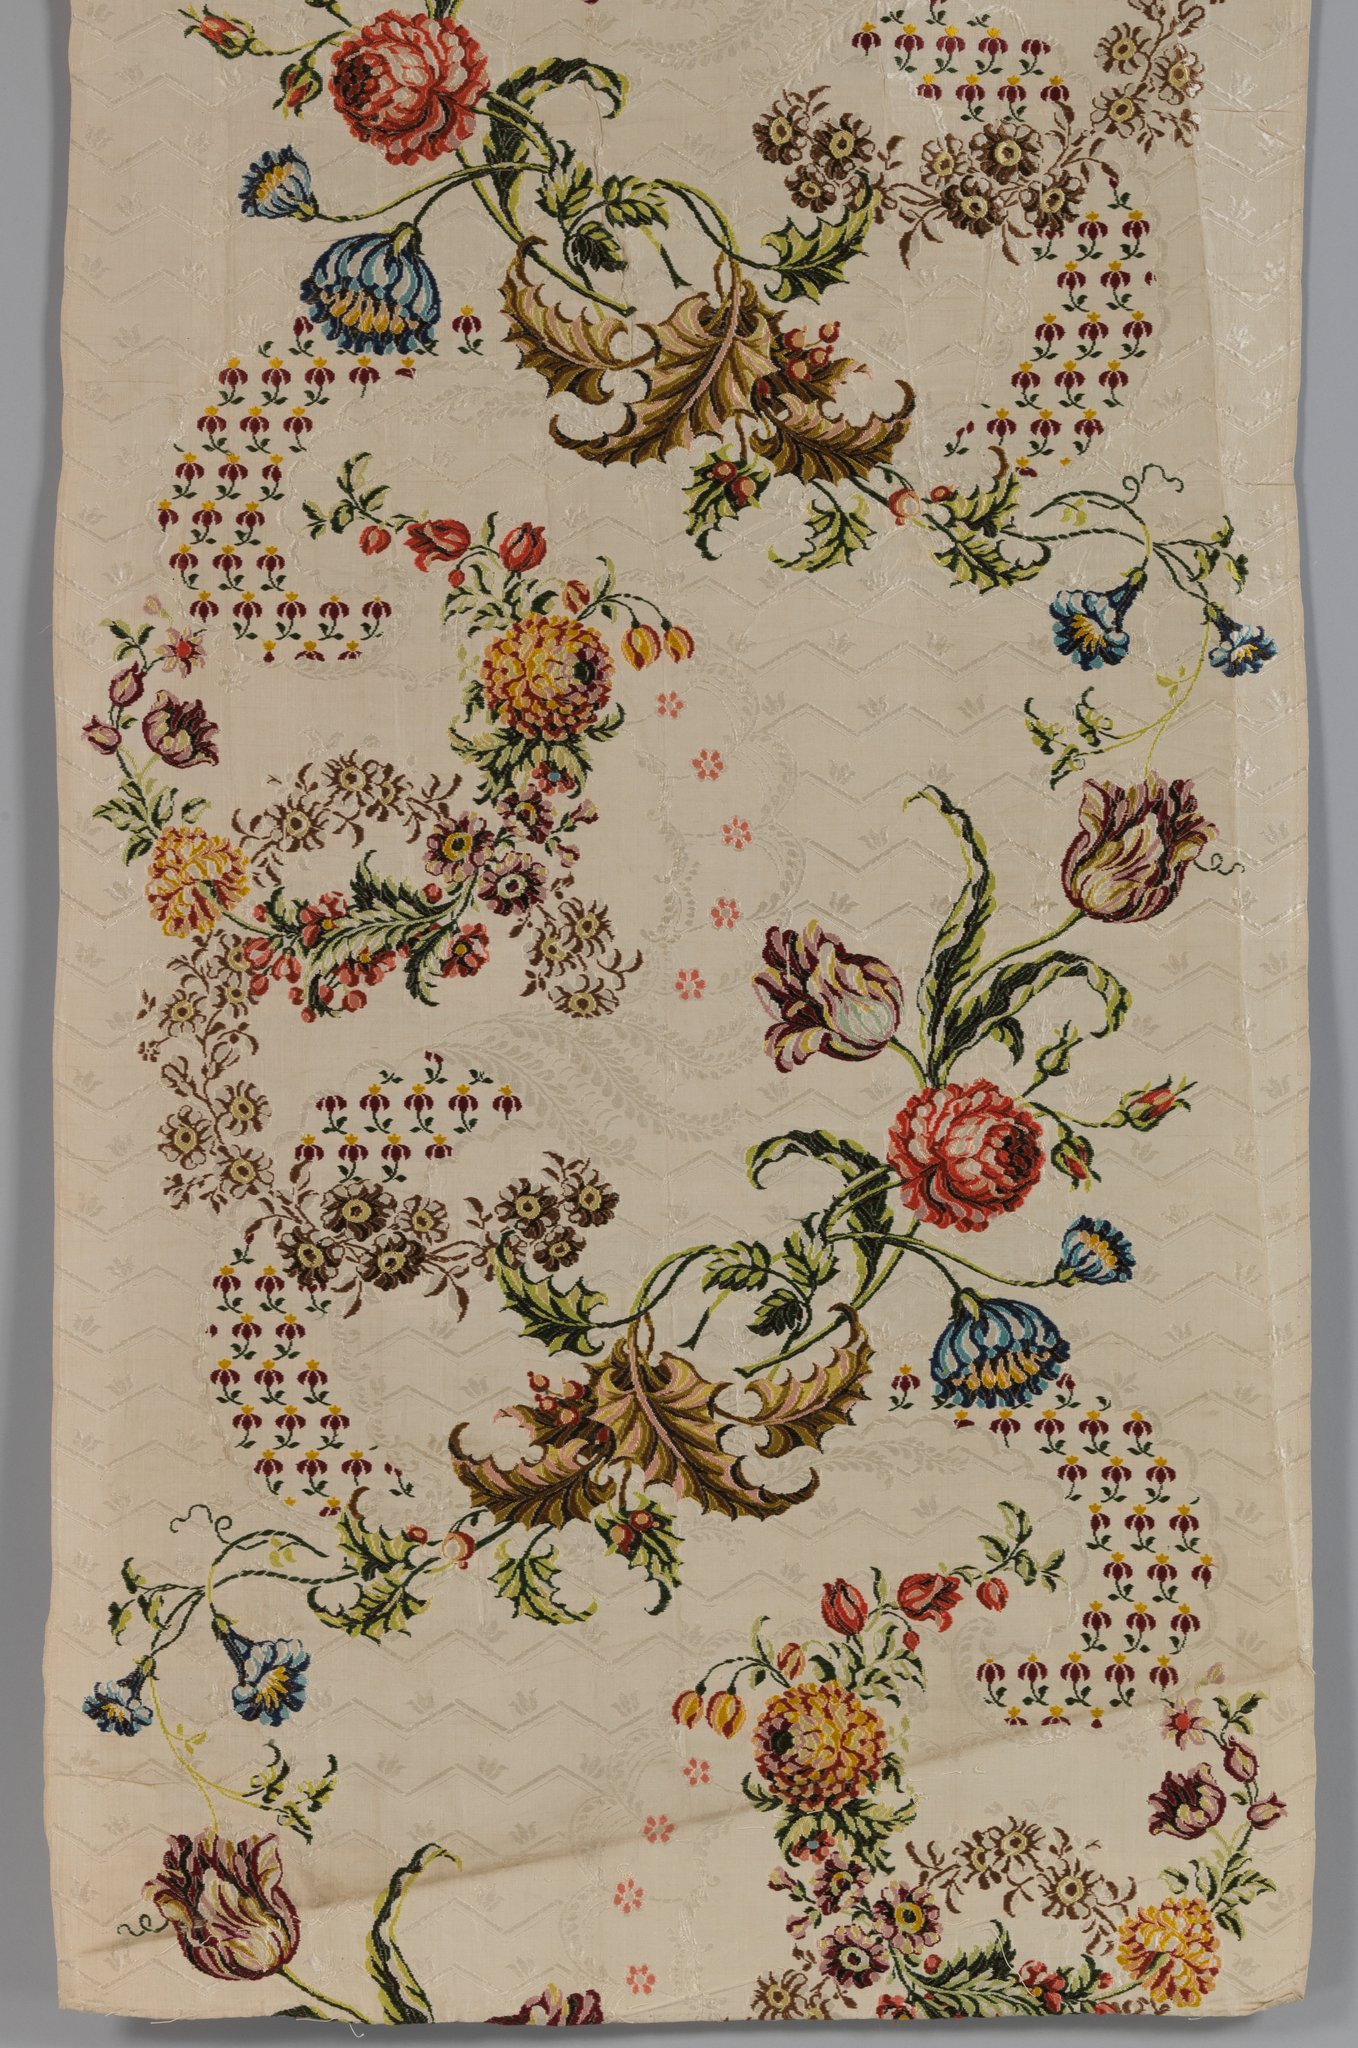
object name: length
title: Length of dress silk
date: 1748-1752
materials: silk